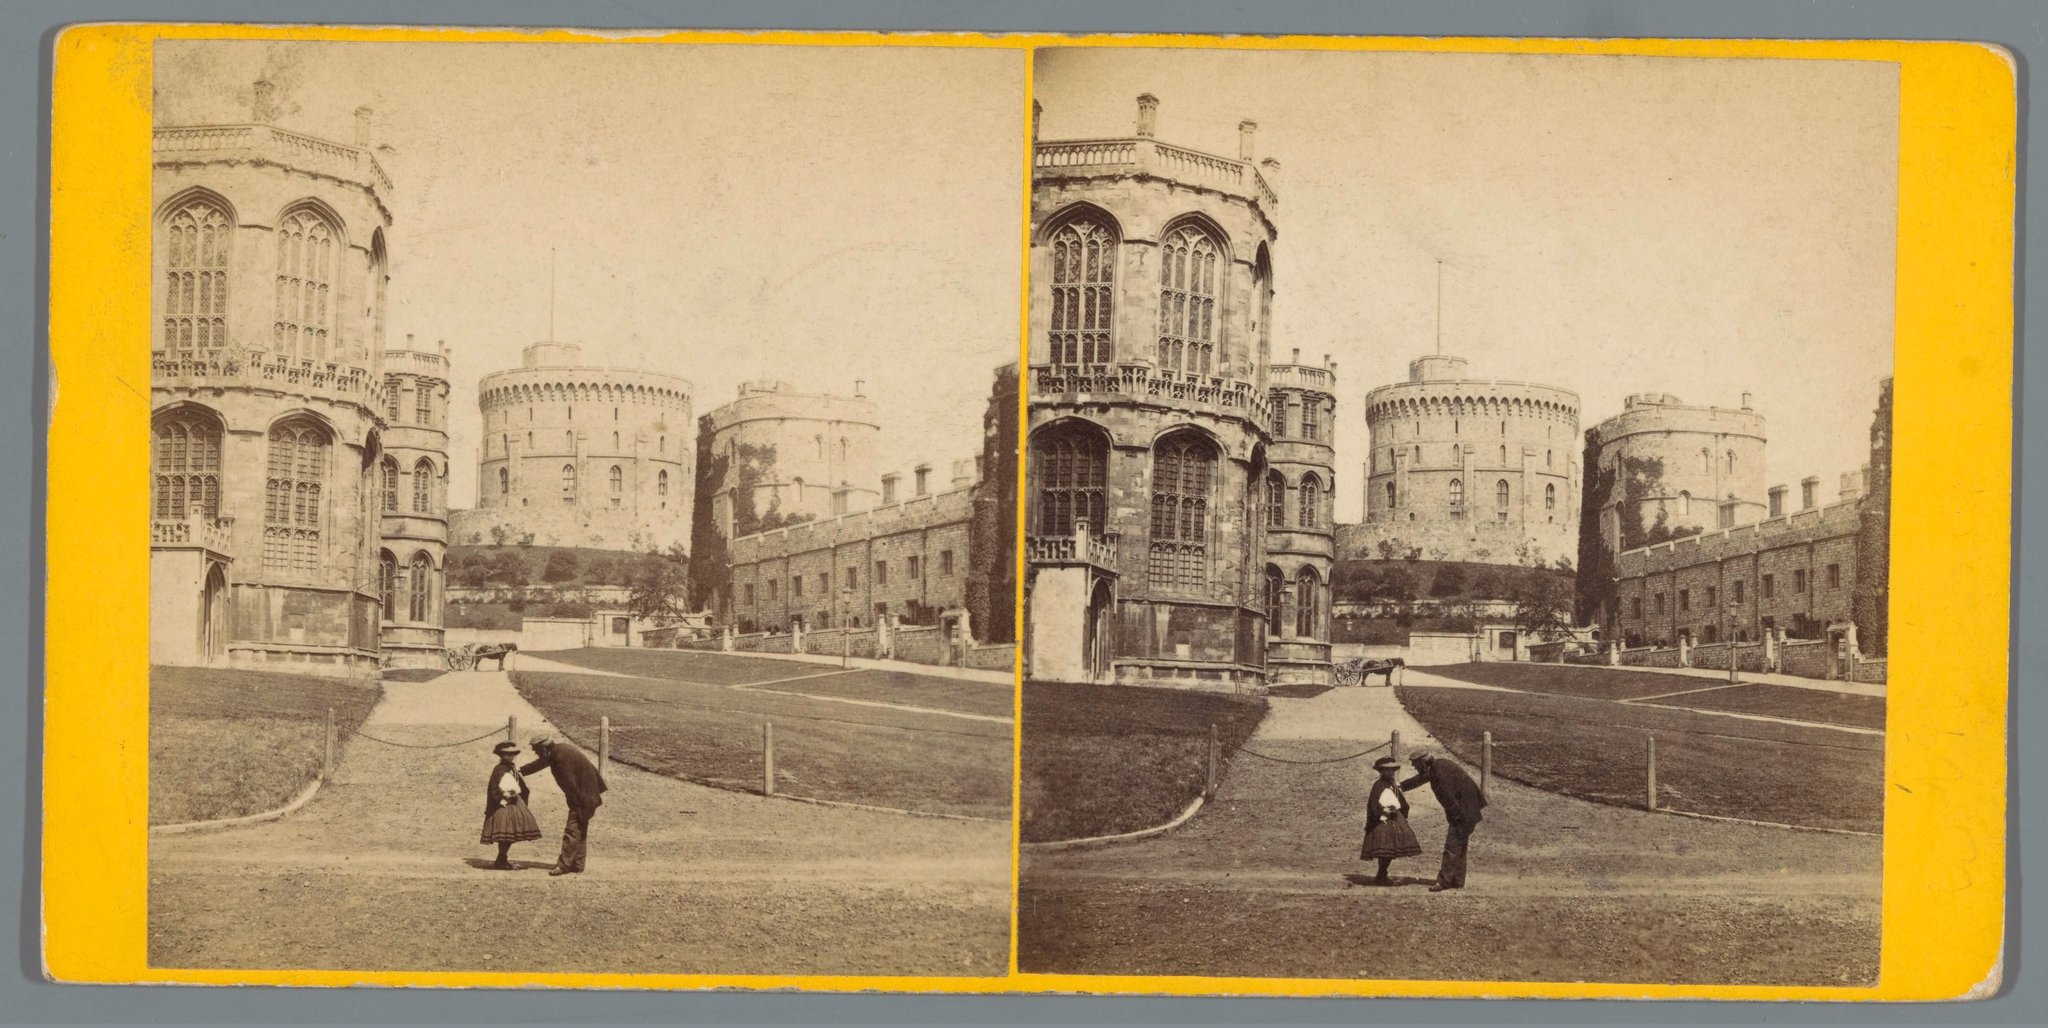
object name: stereograph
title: Windsor Castle – The Round Tower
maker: george washington wilson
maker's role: publisher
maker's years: 1823-1893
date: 1860-1865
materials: cardboard, photographic support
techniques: albumen print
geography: aberdeen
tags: schotland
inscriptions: label: ‘G.W. Wilson & Co, Aberdeen No. 442 Windsor Castle – The Round Tower’